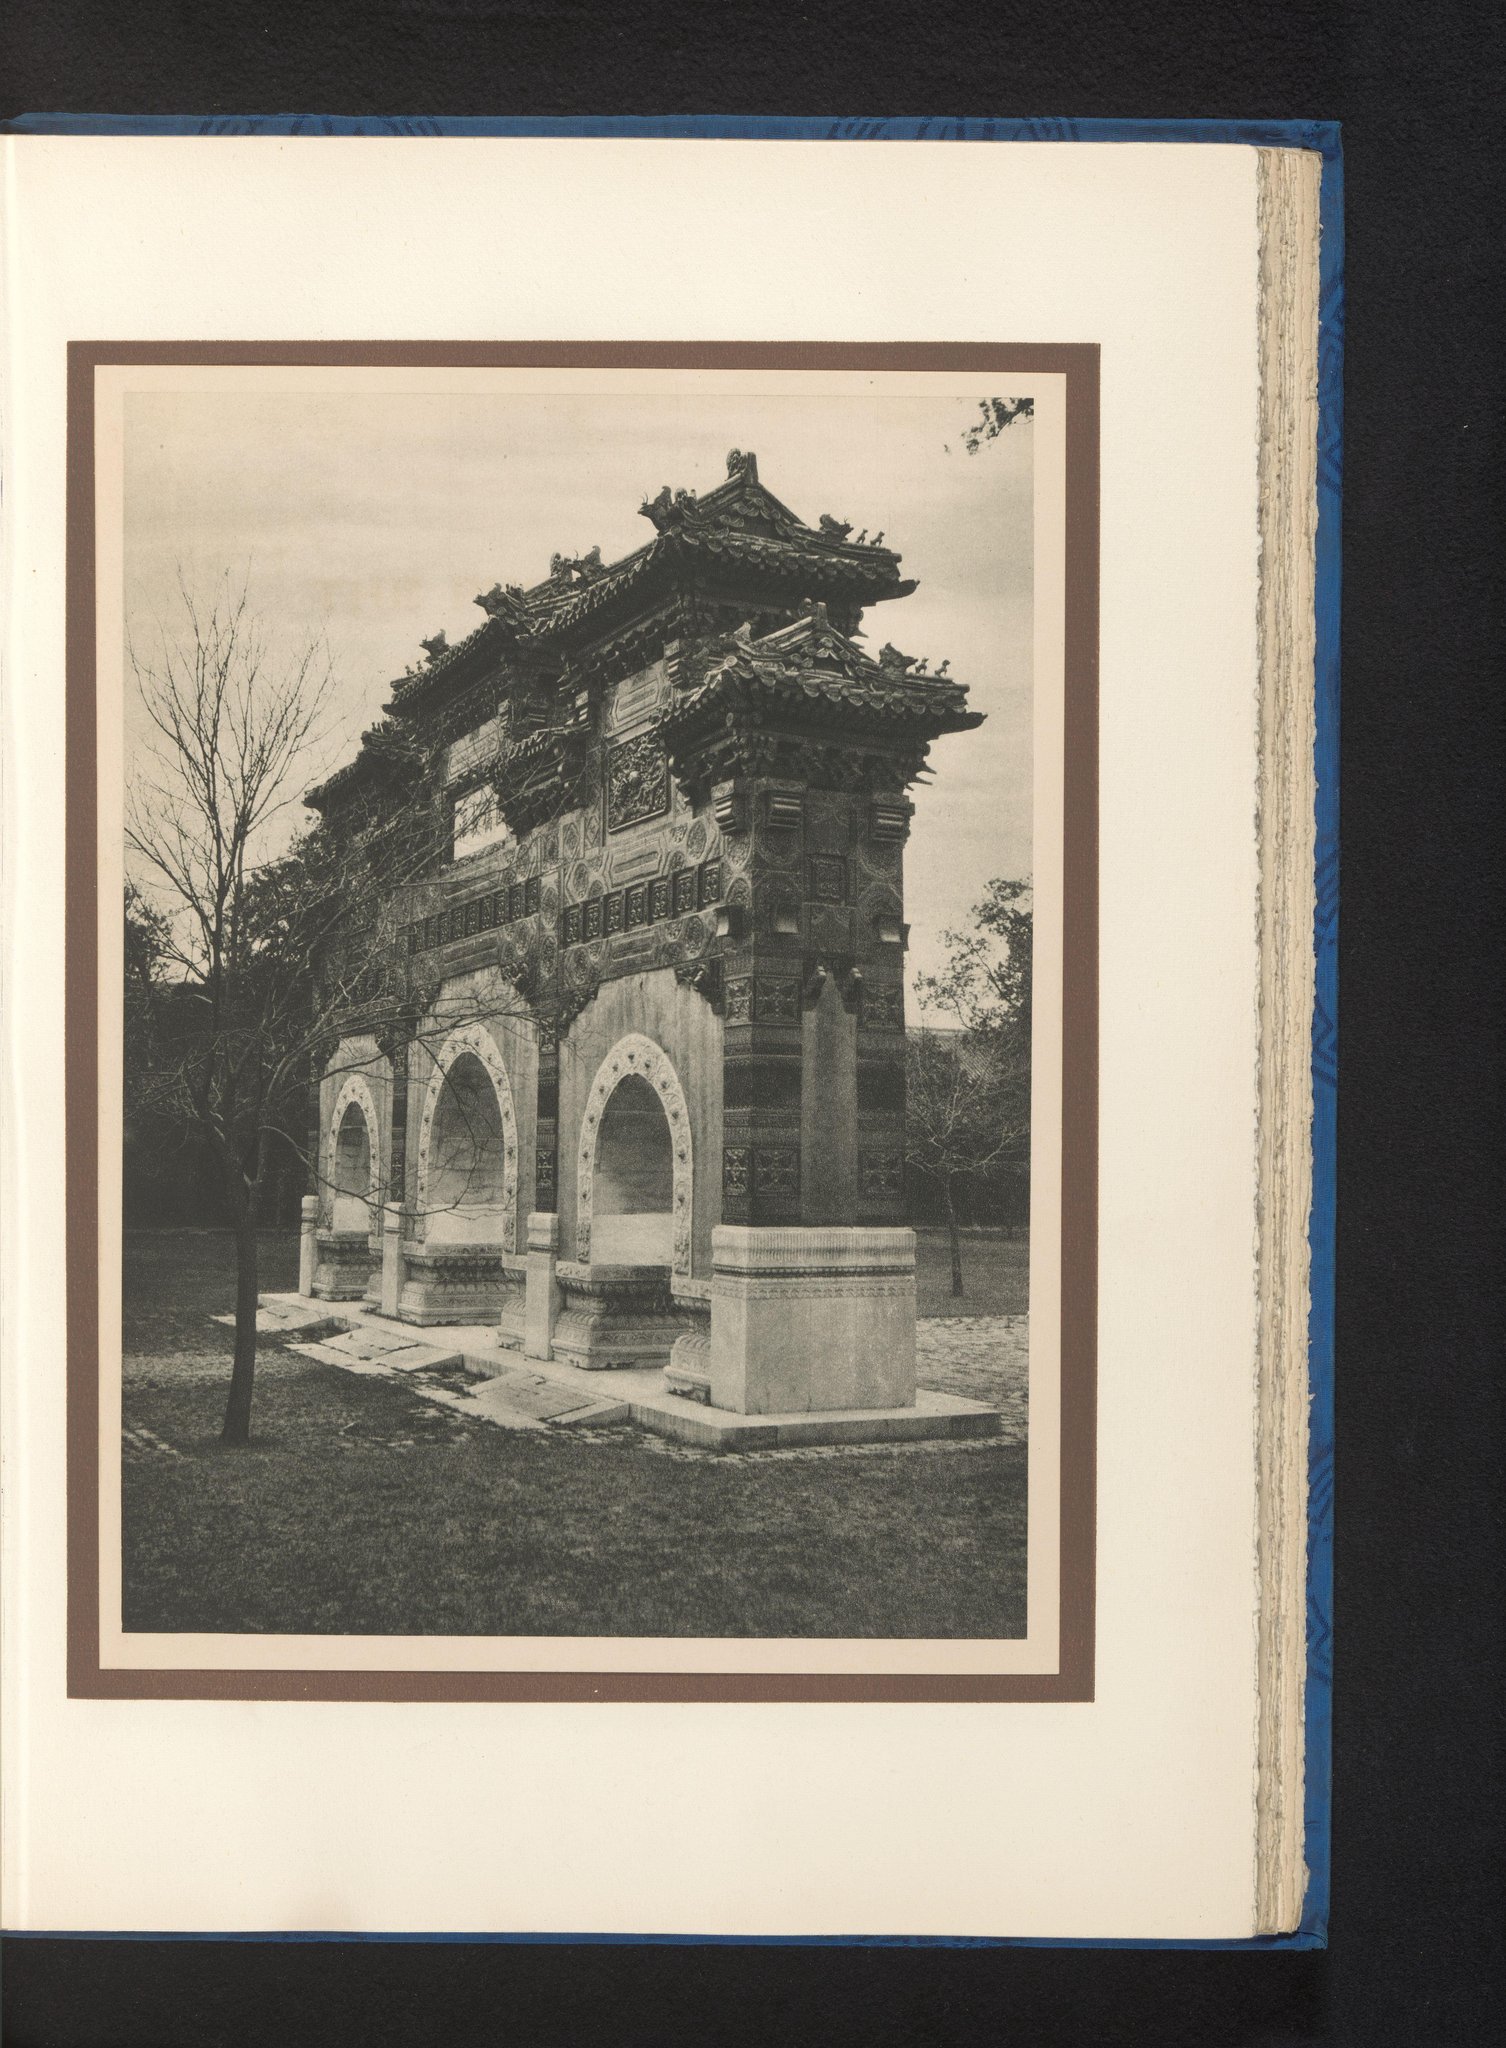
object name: page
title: Paifang bij de Confuciustempel te Peking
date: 1915-1920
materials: paper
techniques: rotogravure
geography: beijing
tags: gate, entrance